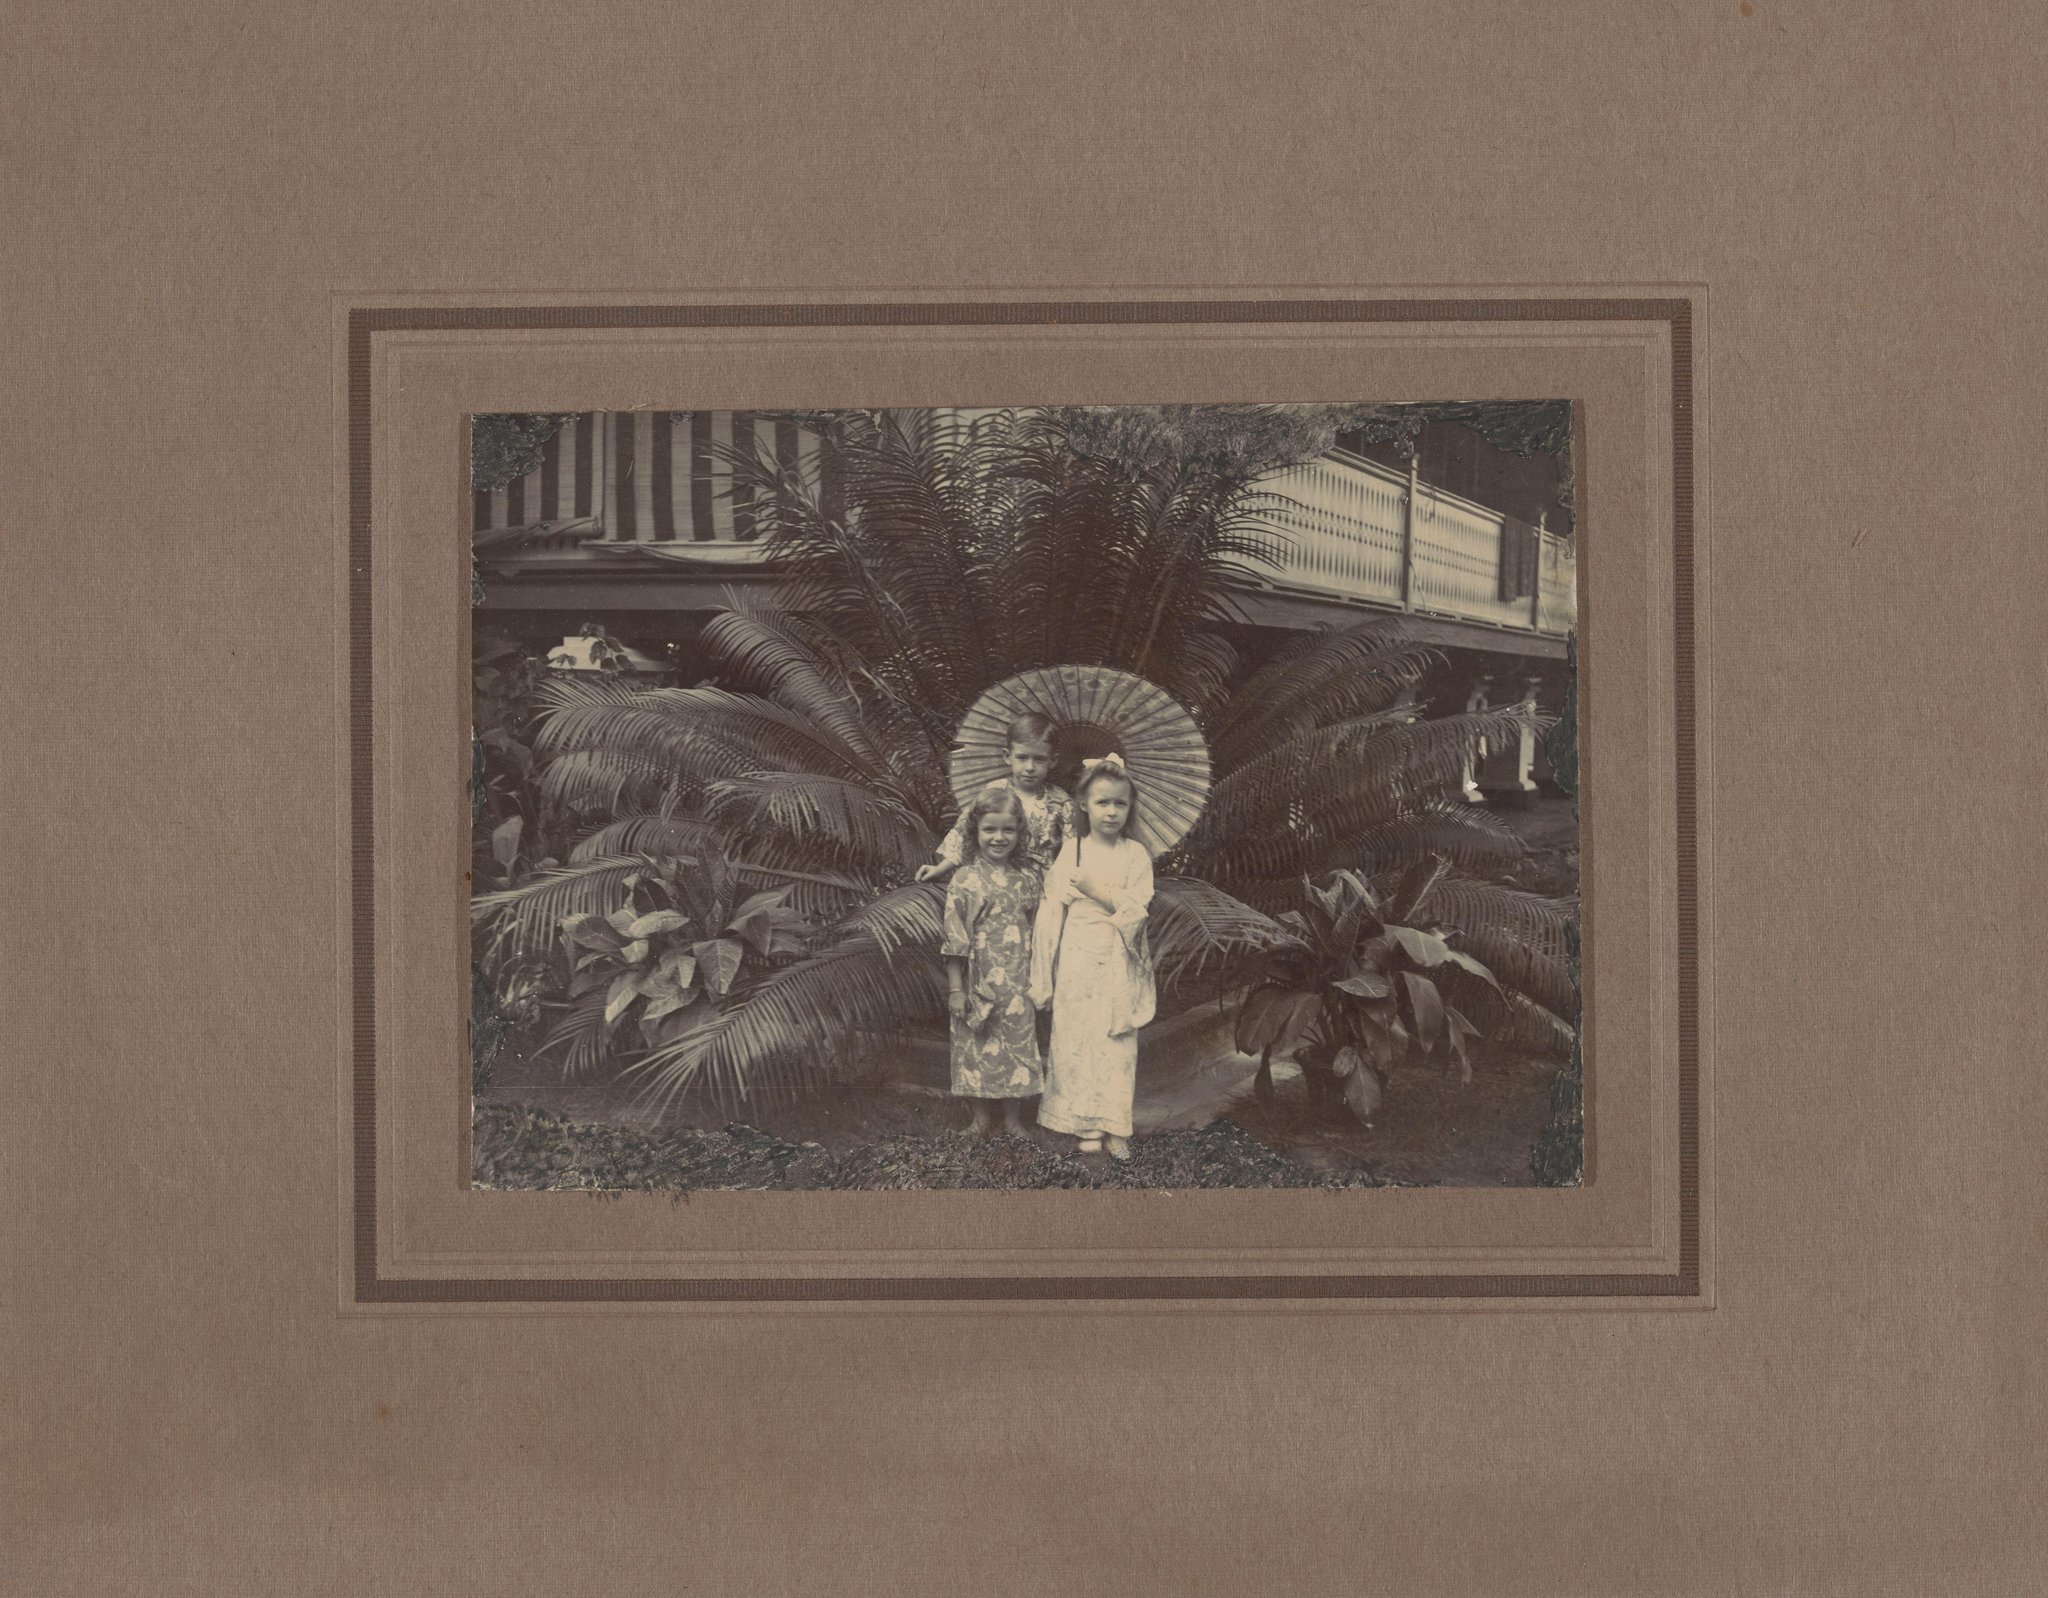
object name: photograph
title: Portret van een drie onbekende kinderen, vermoedelijk gerelateerd aan de familie Marmelstein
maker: Anonymous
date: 1900-1940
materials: paper, cardboard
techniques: gelatin silver print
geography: amsterdam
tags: child, historical persons